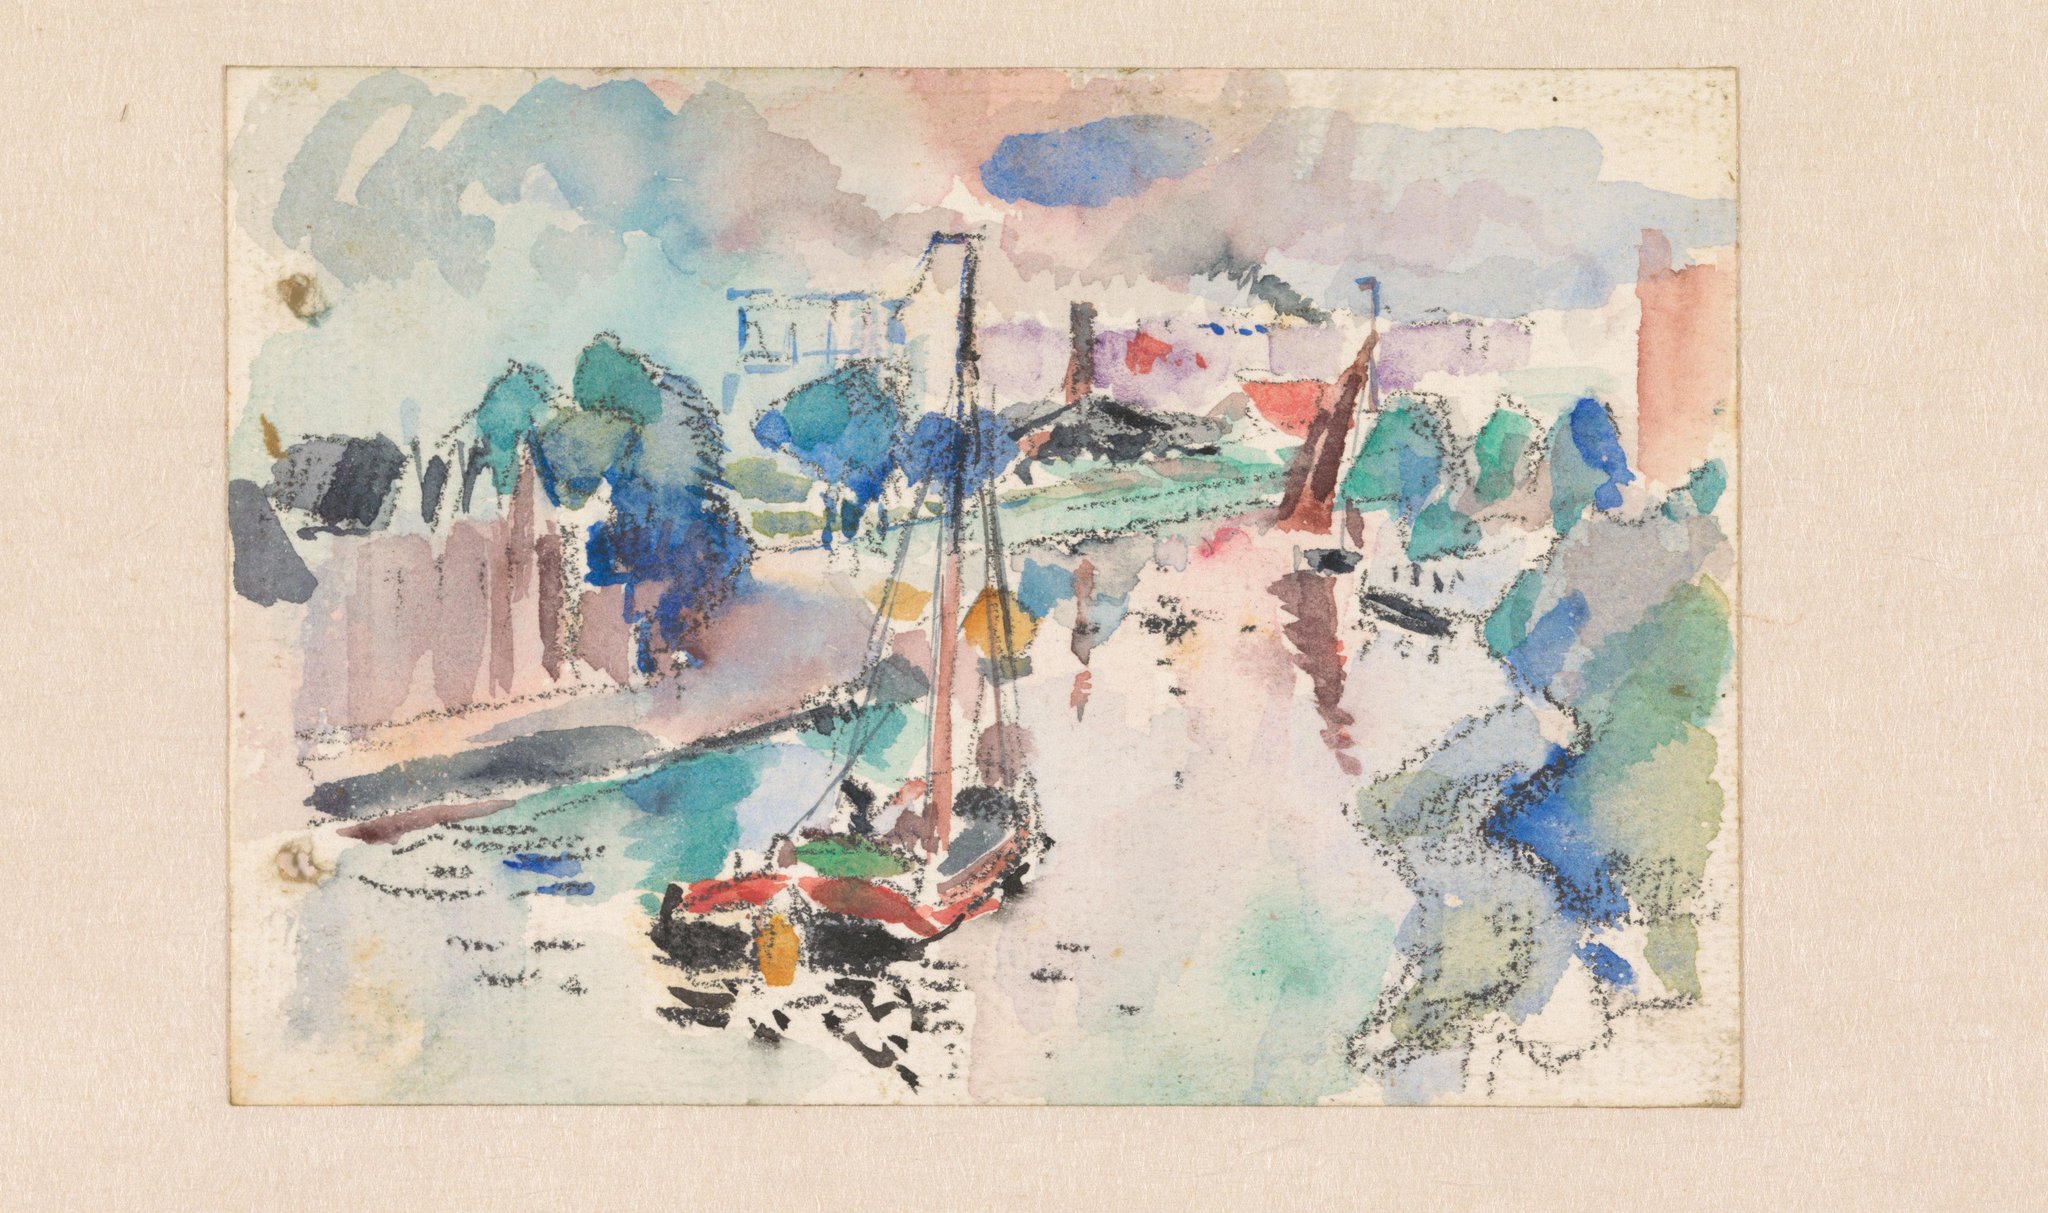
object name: drawing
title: De Kostverloren Vaart te Amsterdam gezien in noordelijke richting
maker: rik wouters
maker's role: draughtsman, print maker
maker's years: 1882-1916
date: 1915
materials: chalk, paper, watercolor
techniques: brush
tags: canals, waters (in city)